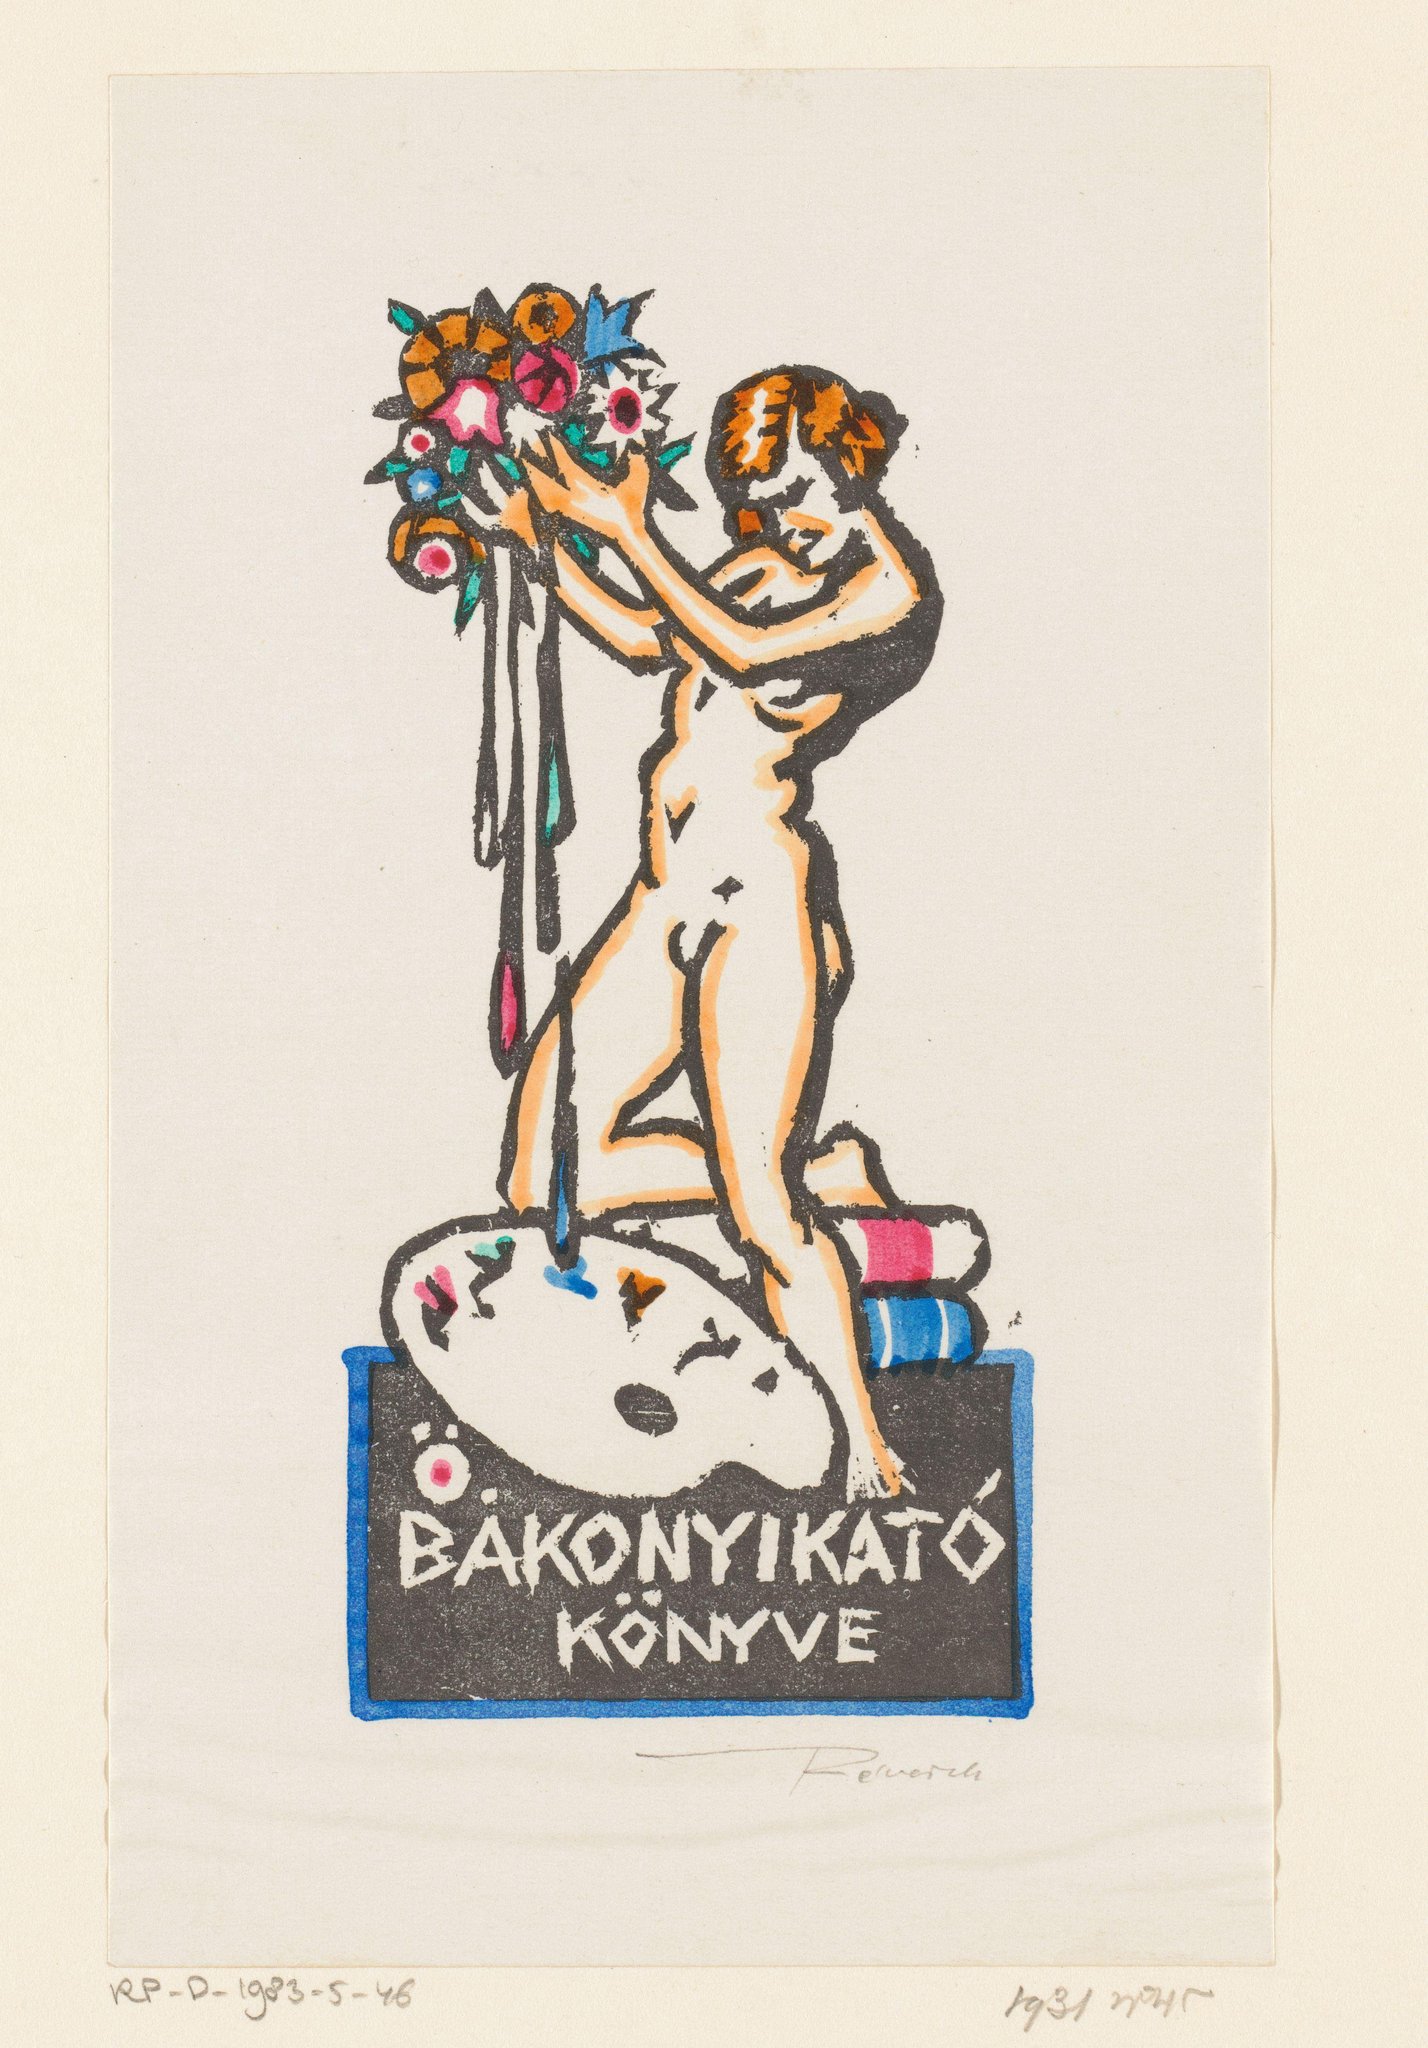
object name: bookplate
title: Ex libris van Kató Bákonyi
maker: kornél révész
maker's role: print maker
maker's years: 1885-1944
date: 1931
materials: paper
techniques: hand coloring, linocut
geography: budapest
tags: cut flowers; nosegay, bunch of flowers, woman (showing herself) undressed, quasi-nude, book, palette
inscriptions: inscription: ‘Lino/ 931’, workshop stamp: ‘Fecit/ Révész Kornél/ Budapest’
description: Ex libris maakt deel uit van omslag met 64 ex libris op 34 losse opzetvellen, een catalogus en een tekstblad.